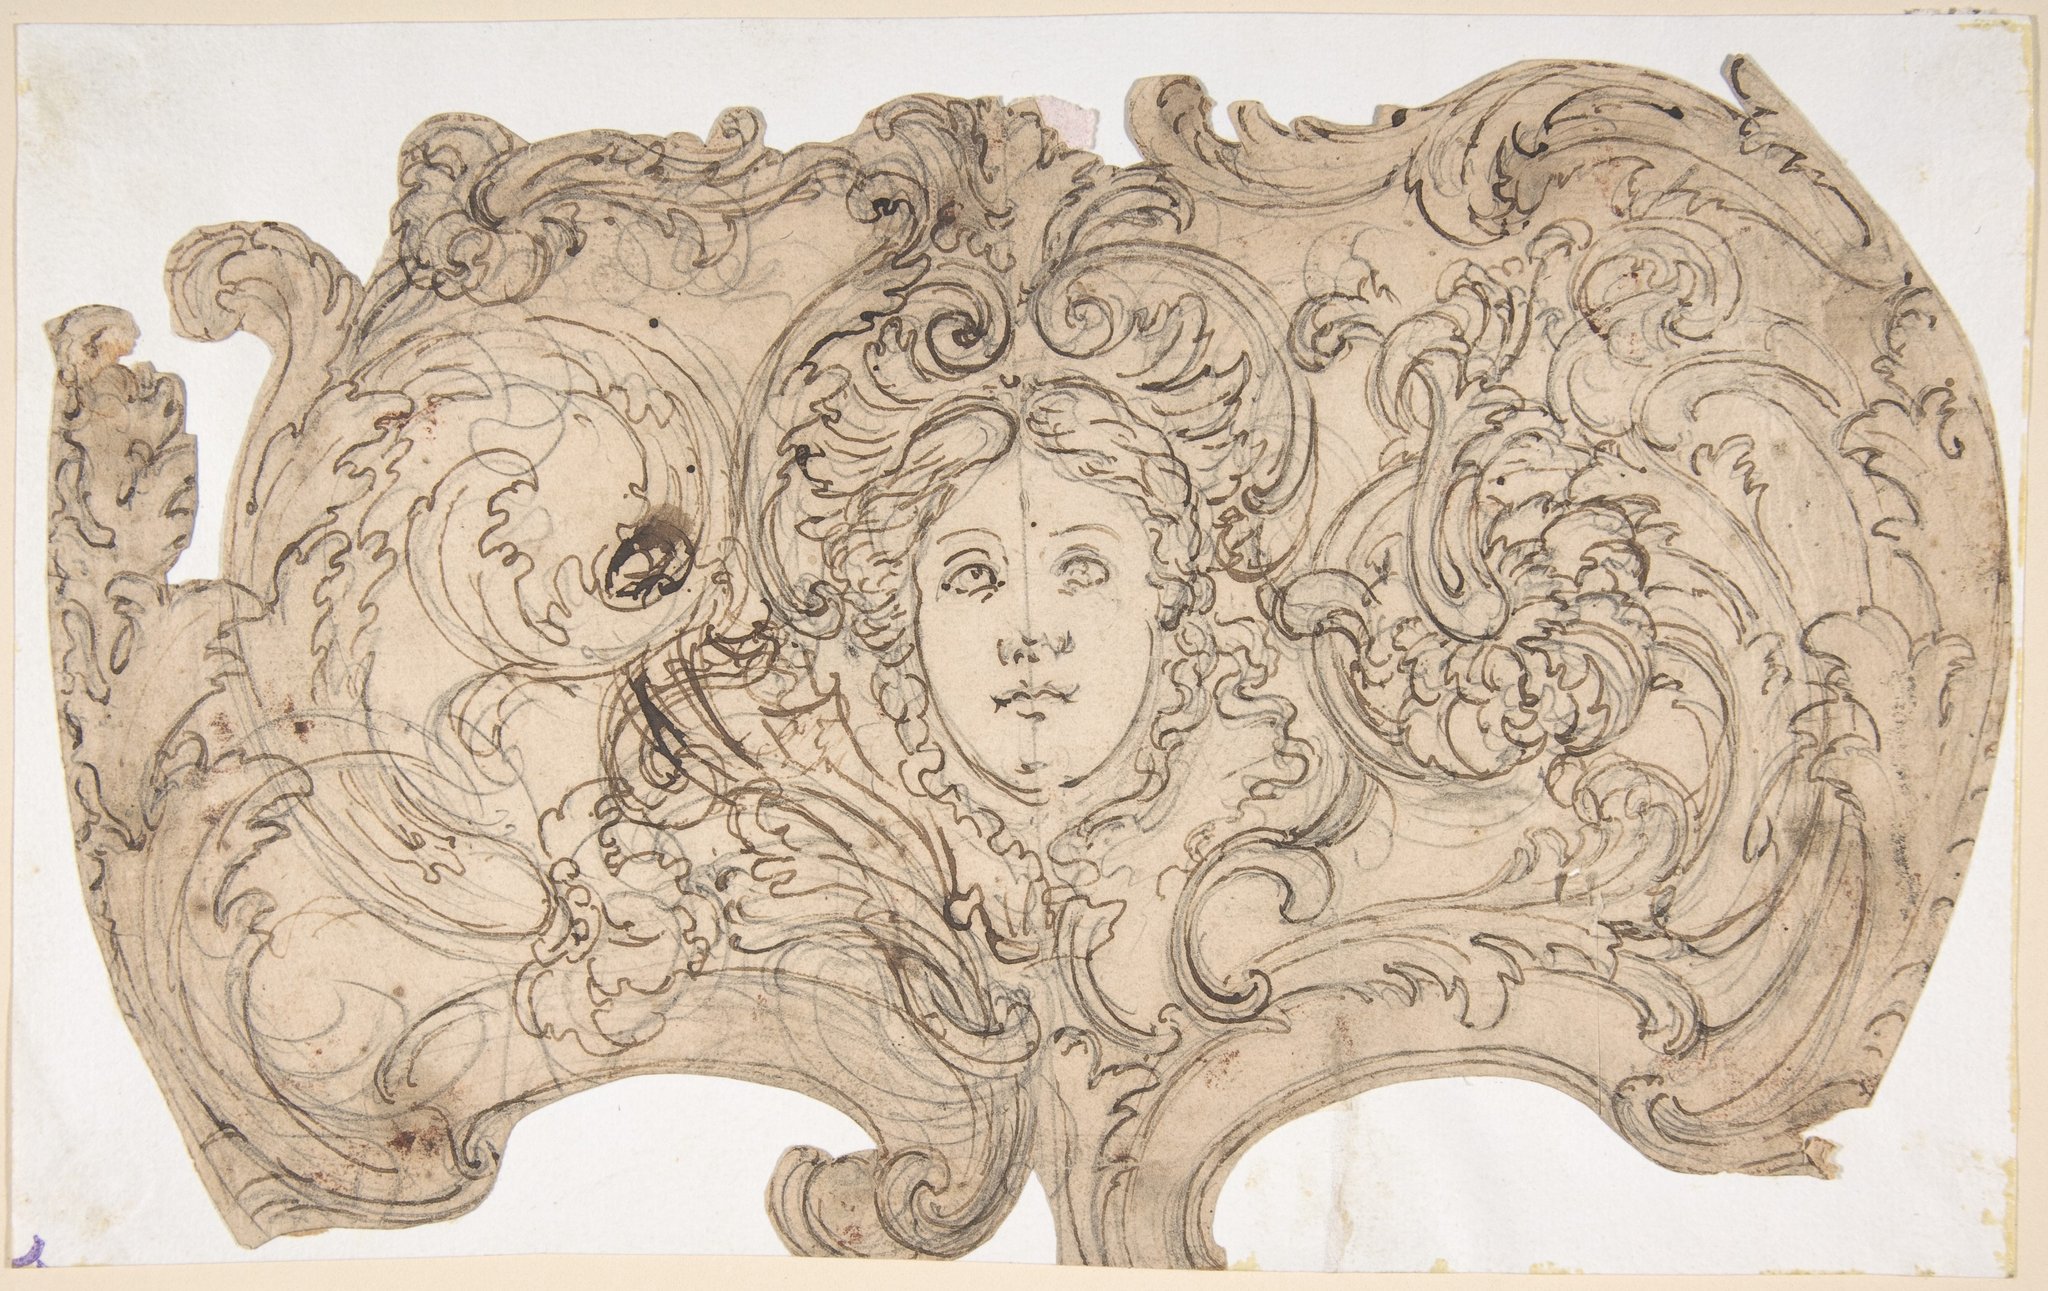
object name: drawing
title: Female Mask Surrounded by Tendrils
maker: giovanni battista foggini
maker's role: artist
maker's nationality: italian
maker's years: 1652-1725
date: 1672-1725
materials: chalk, ink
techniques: pen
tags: masks,women